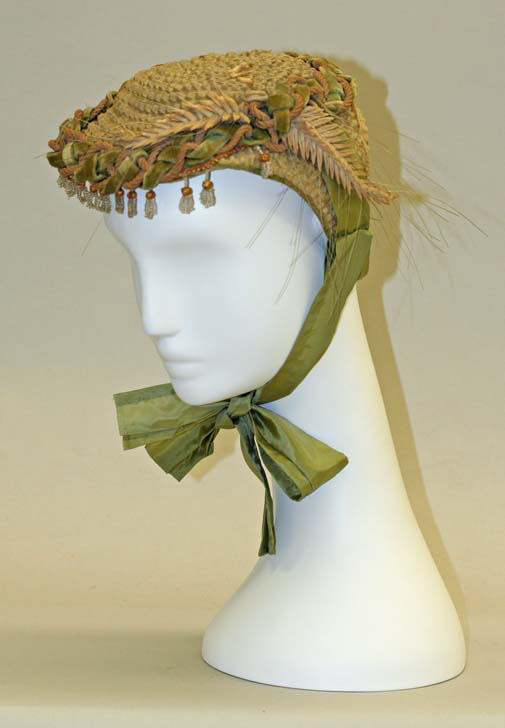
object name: bonnet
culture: american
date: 1864-1867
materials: hair, silk